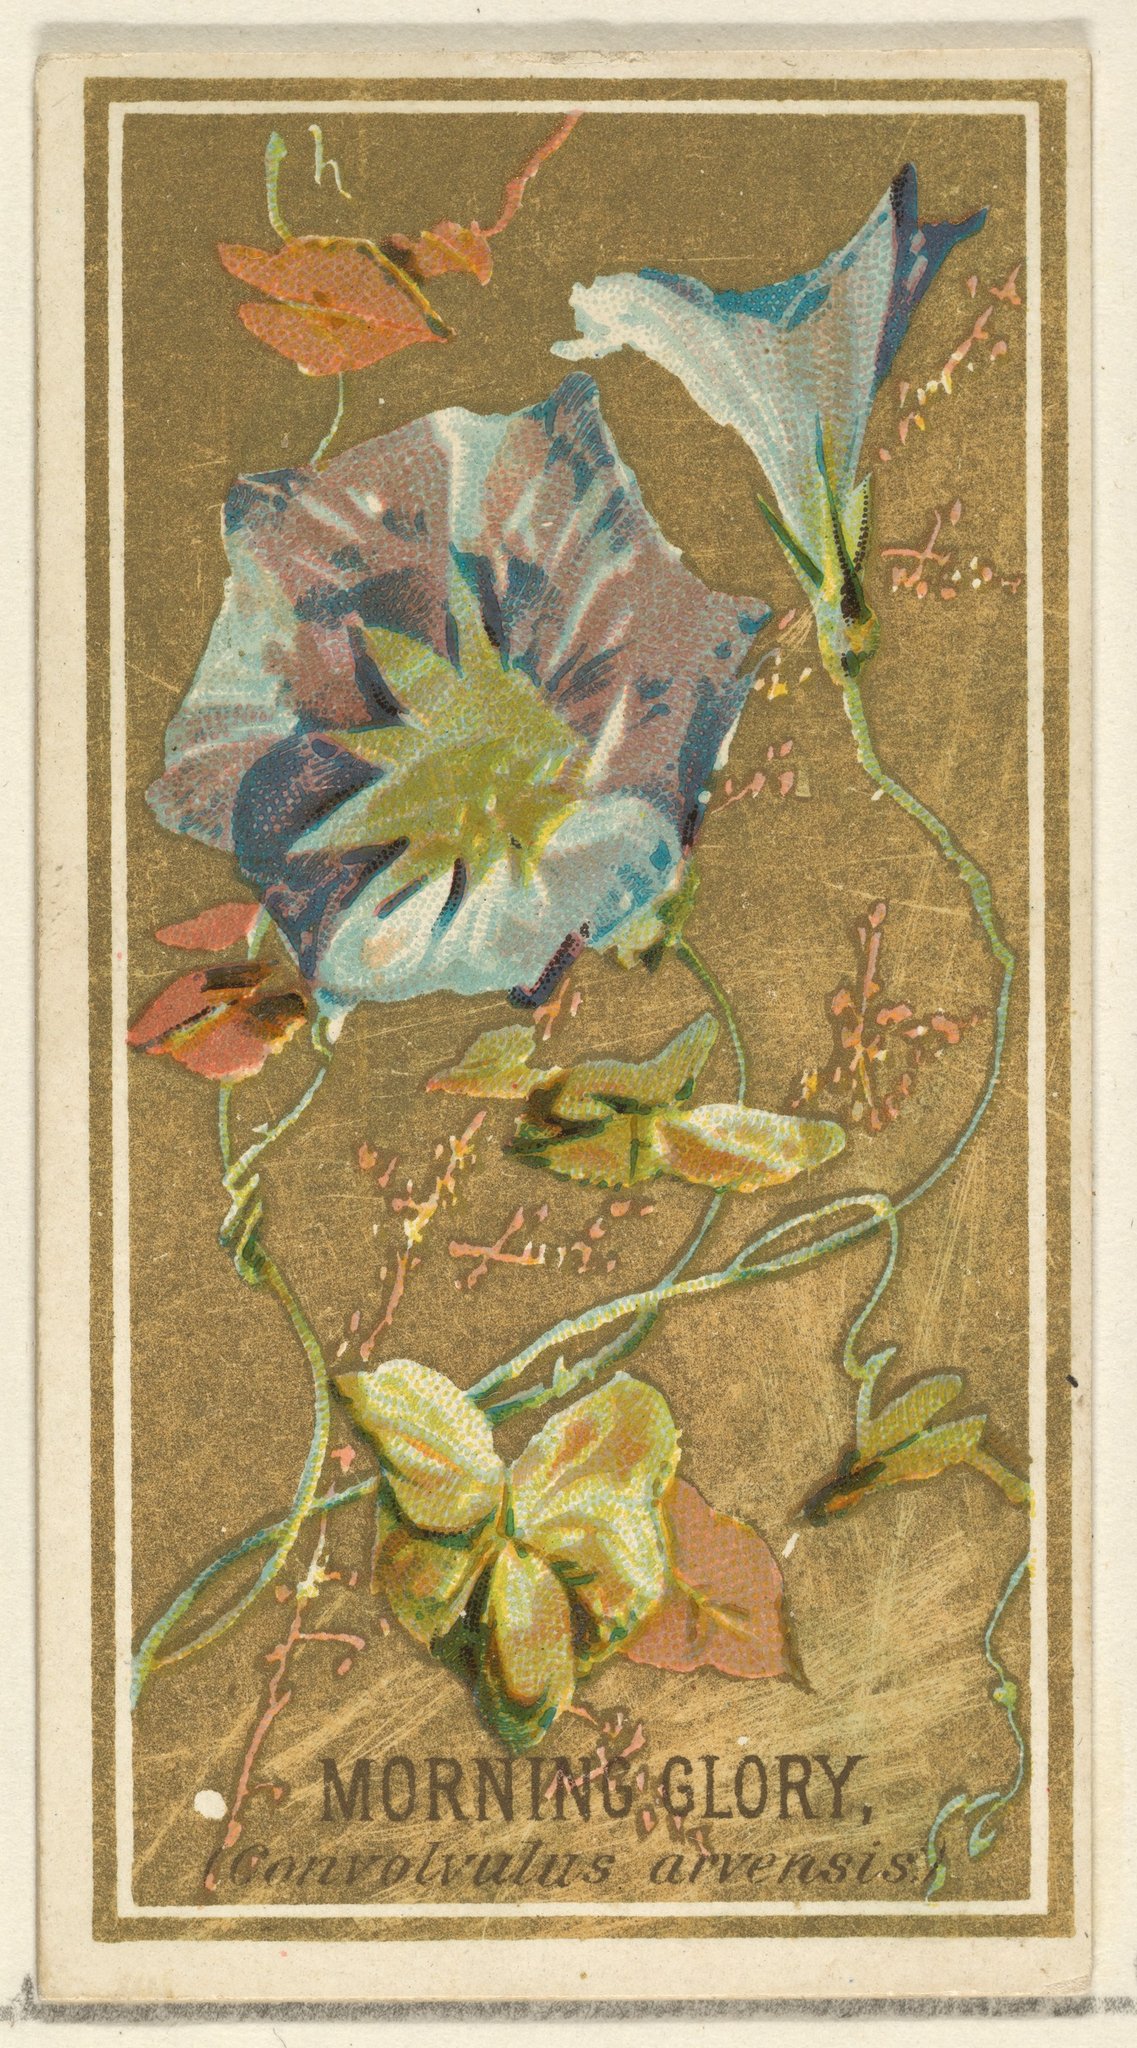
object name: print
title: Morning Glory (Convolvalus arrensis), from the Flowers series for Old Judge Cigarettes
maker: goodwin & company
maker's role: publisher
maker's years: 1850-1950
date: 1890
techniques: color lithograph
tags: flowers,leaves